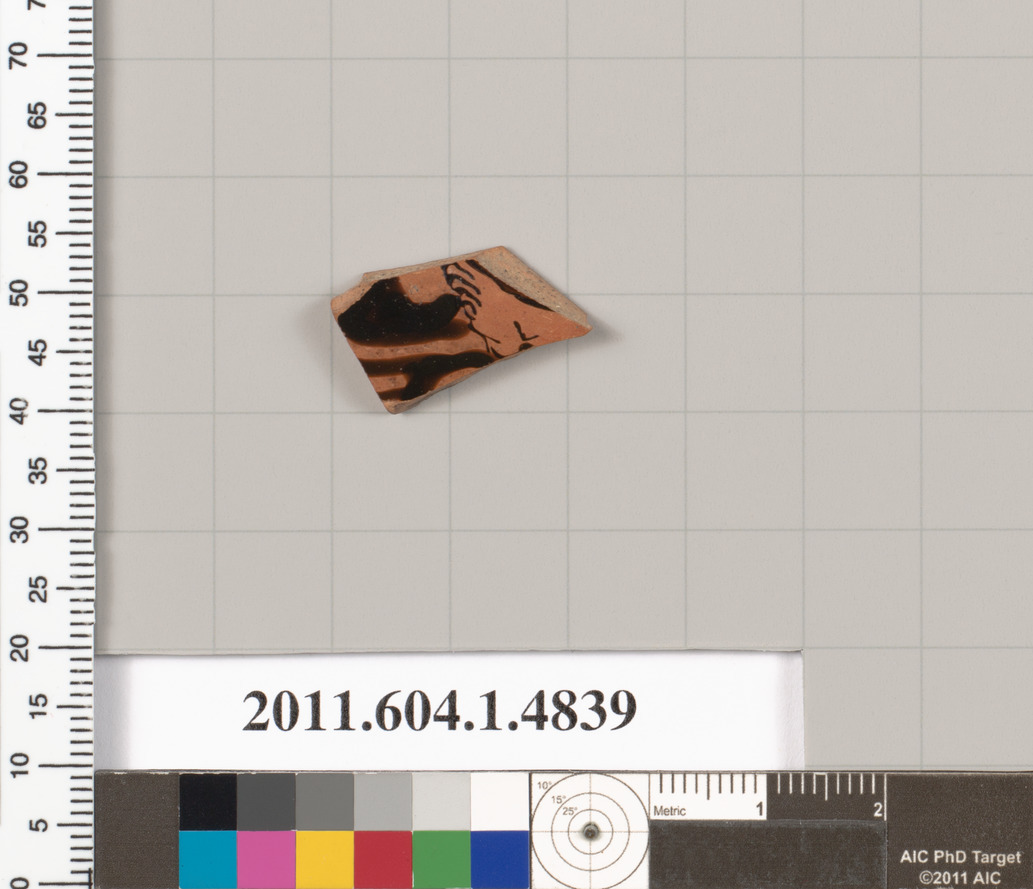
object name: kylix fragment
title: Terracotta fragment of a kylix (drinking cup)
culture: greek, attic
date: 500-480 BCE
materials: terracotta